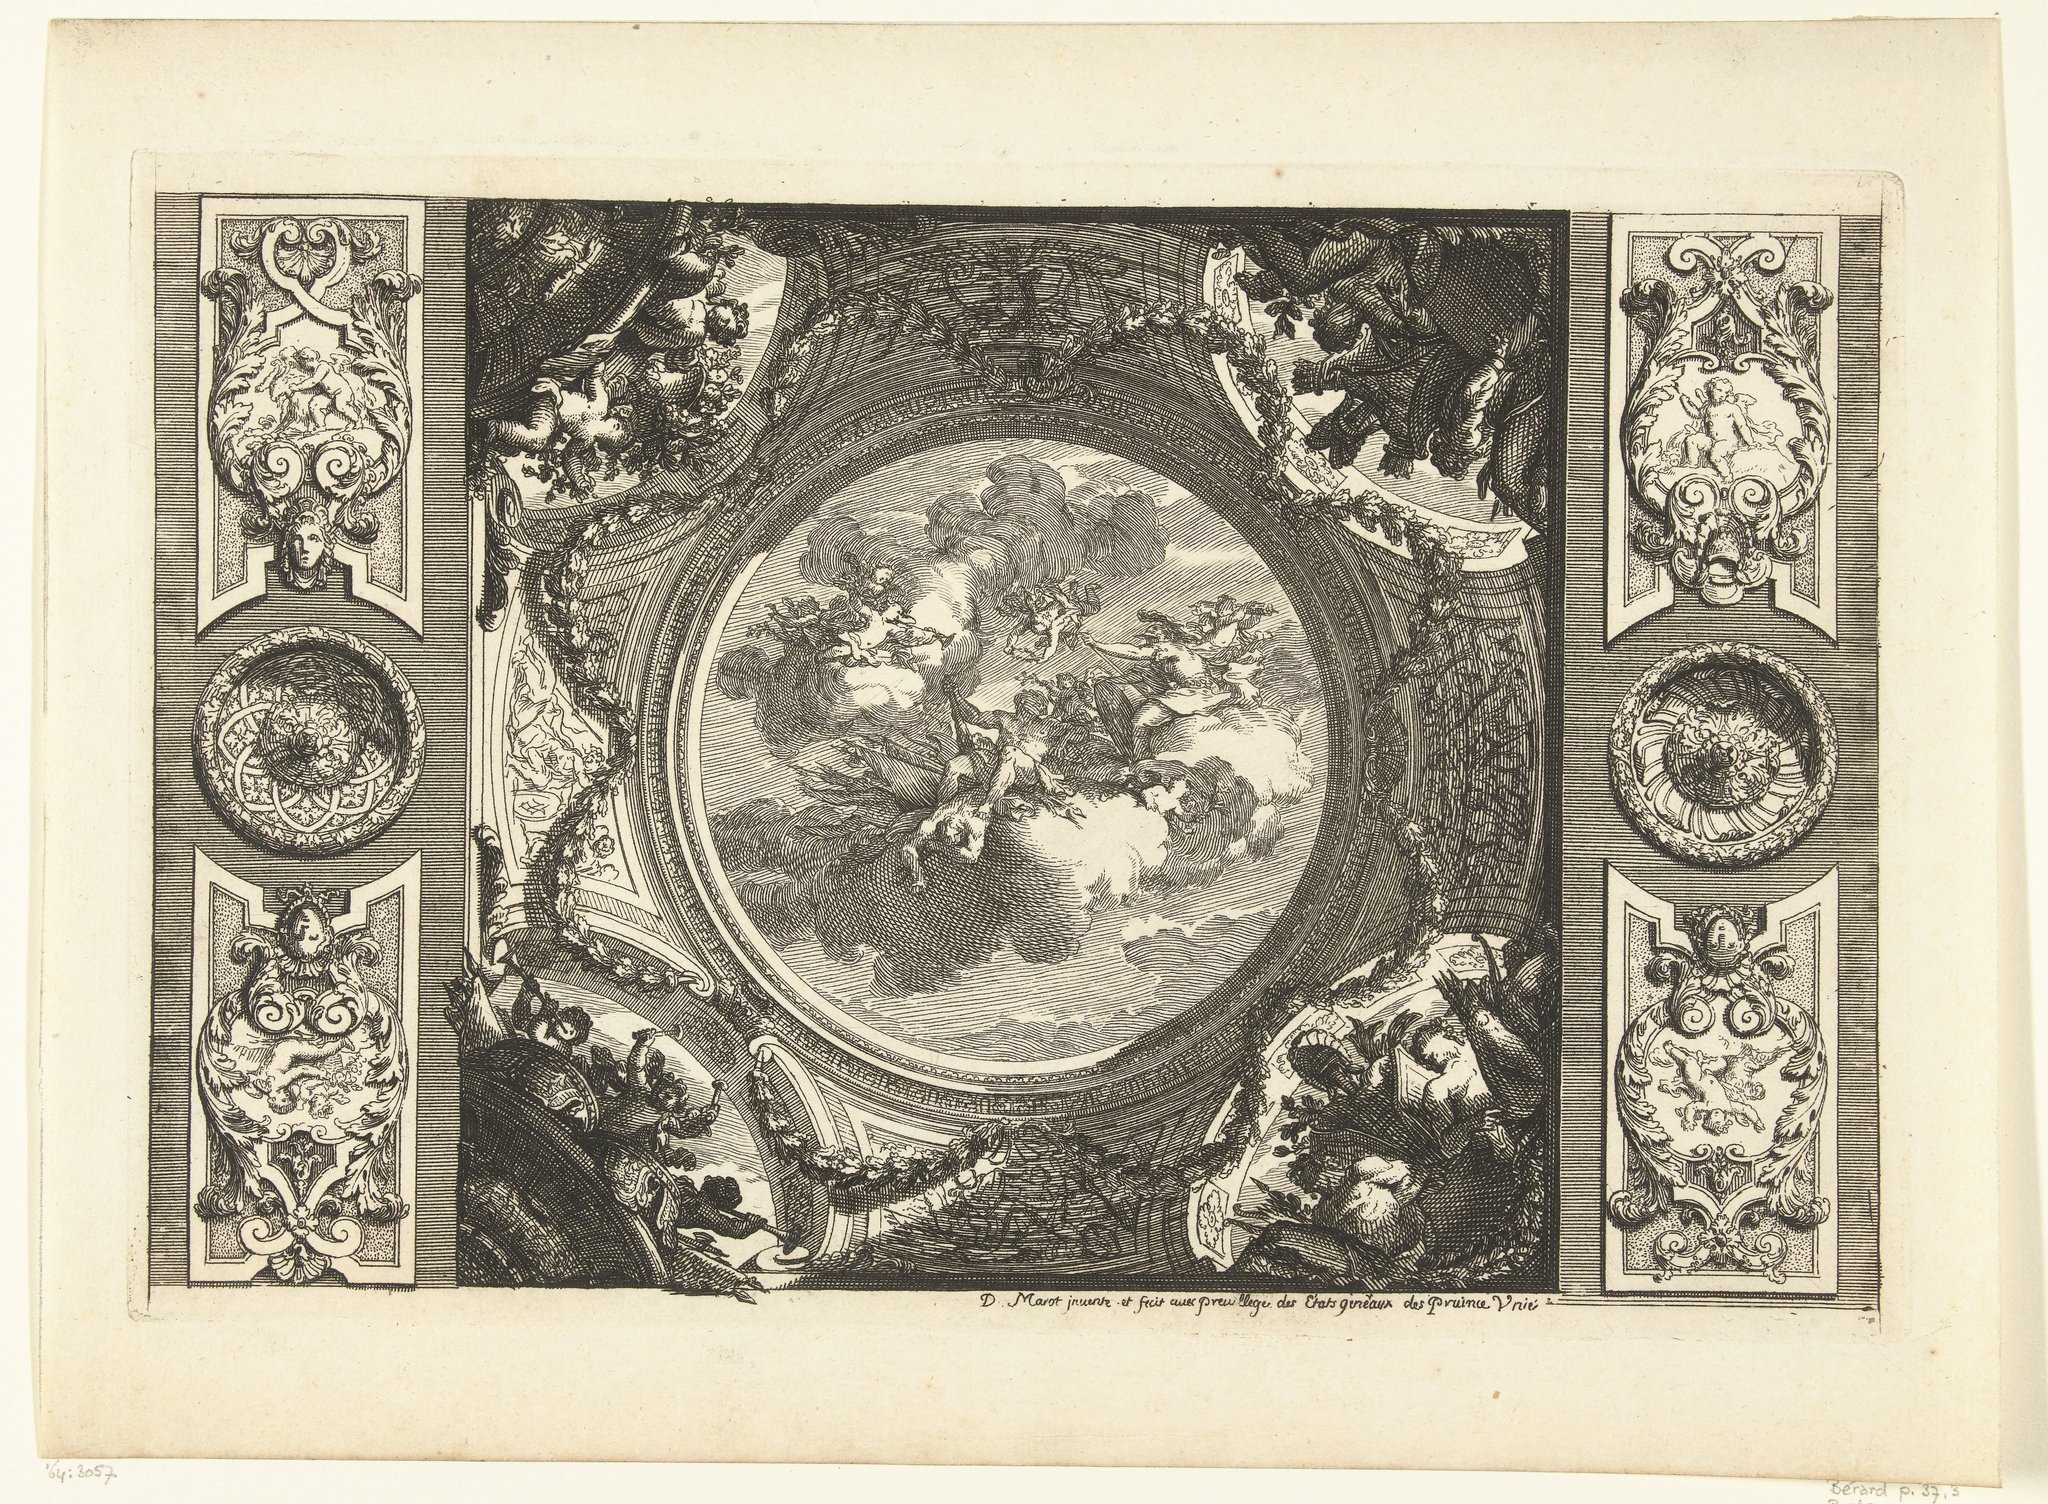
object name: ornament print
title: Vierkant plafond met Hercules en Minerva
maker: daniël marot (i)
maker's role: draughtsman, print maker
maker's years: 1661-1752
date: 1712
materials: paper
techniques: etching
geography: netherlands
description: Vierkant plafond met rond paneel met kroning van Hercules door Minerva. In de hoeken vier bogen met putti en wapentrofeeën geflankeerd door zittende figuren. Aan de zijkanten een brede balk met rozetten en medaillons met putti. Uit serie van 6 (mogelijk 12) bladen.